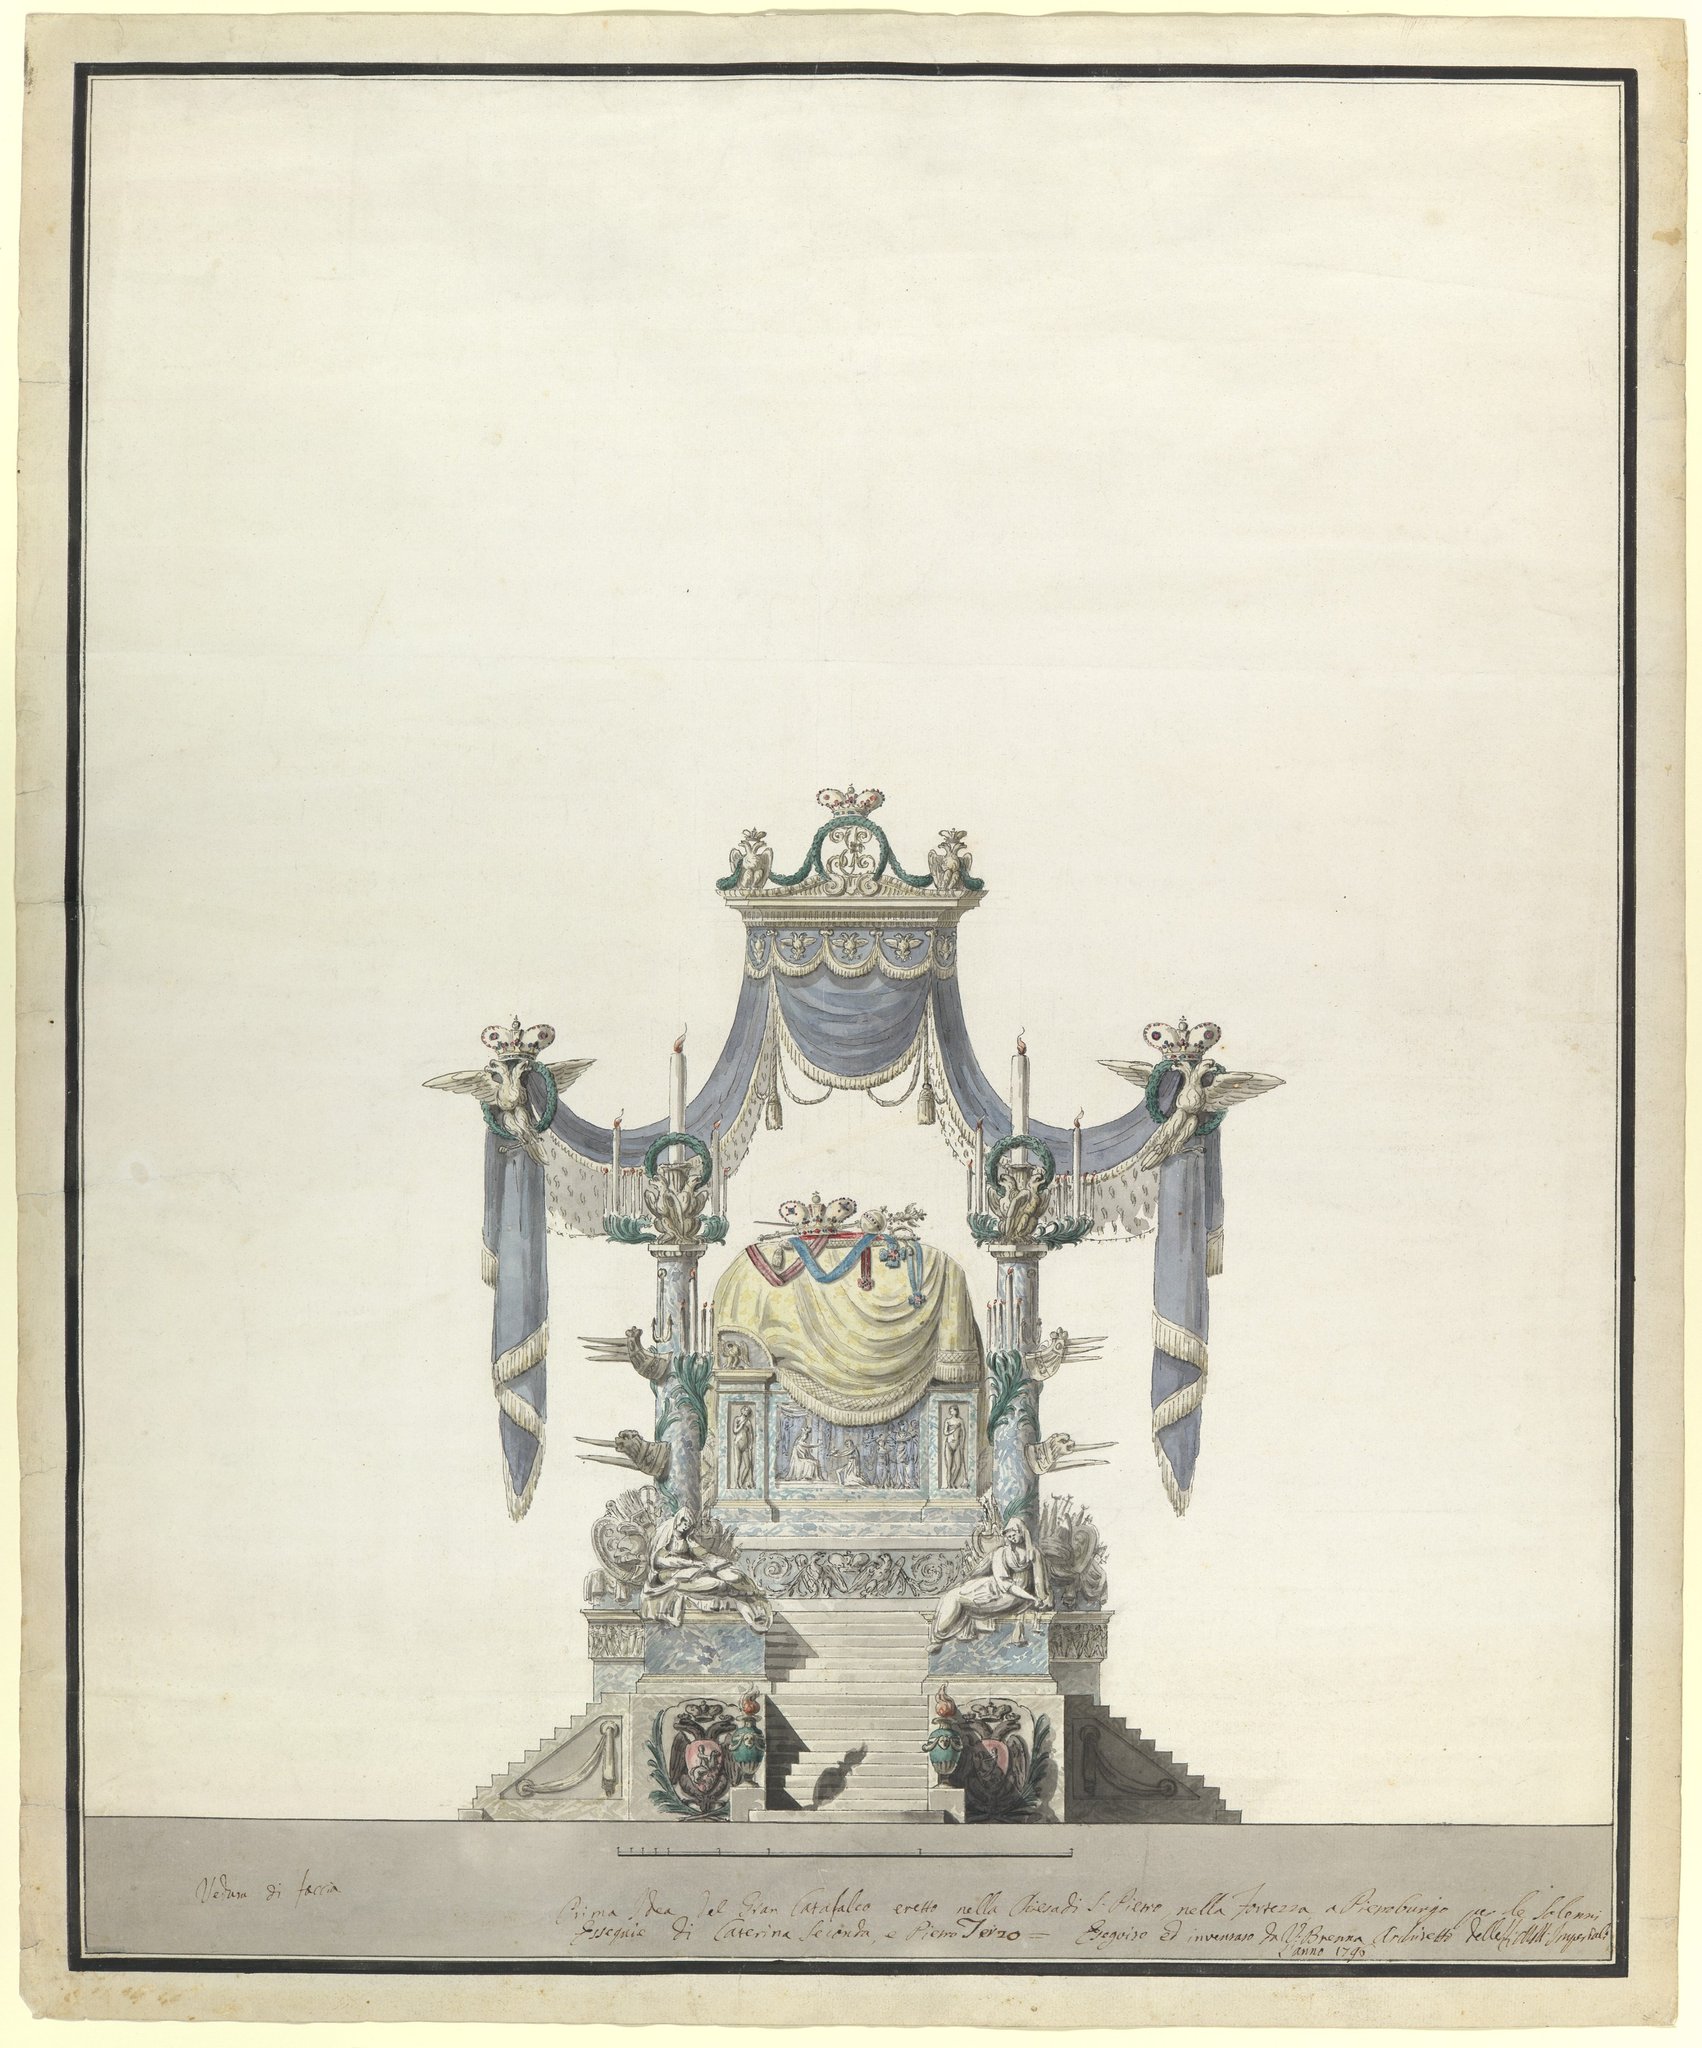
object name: drawing ornament architecture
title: Catafalque for the Empress Catherine the Great of Russia (Front Elevation).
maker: vincenzo brenna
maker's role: artist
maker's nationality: italian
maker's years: 1745-1820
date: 1796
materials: graphite, ink, drawing material, watercolor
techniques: brush, pen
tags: architecture